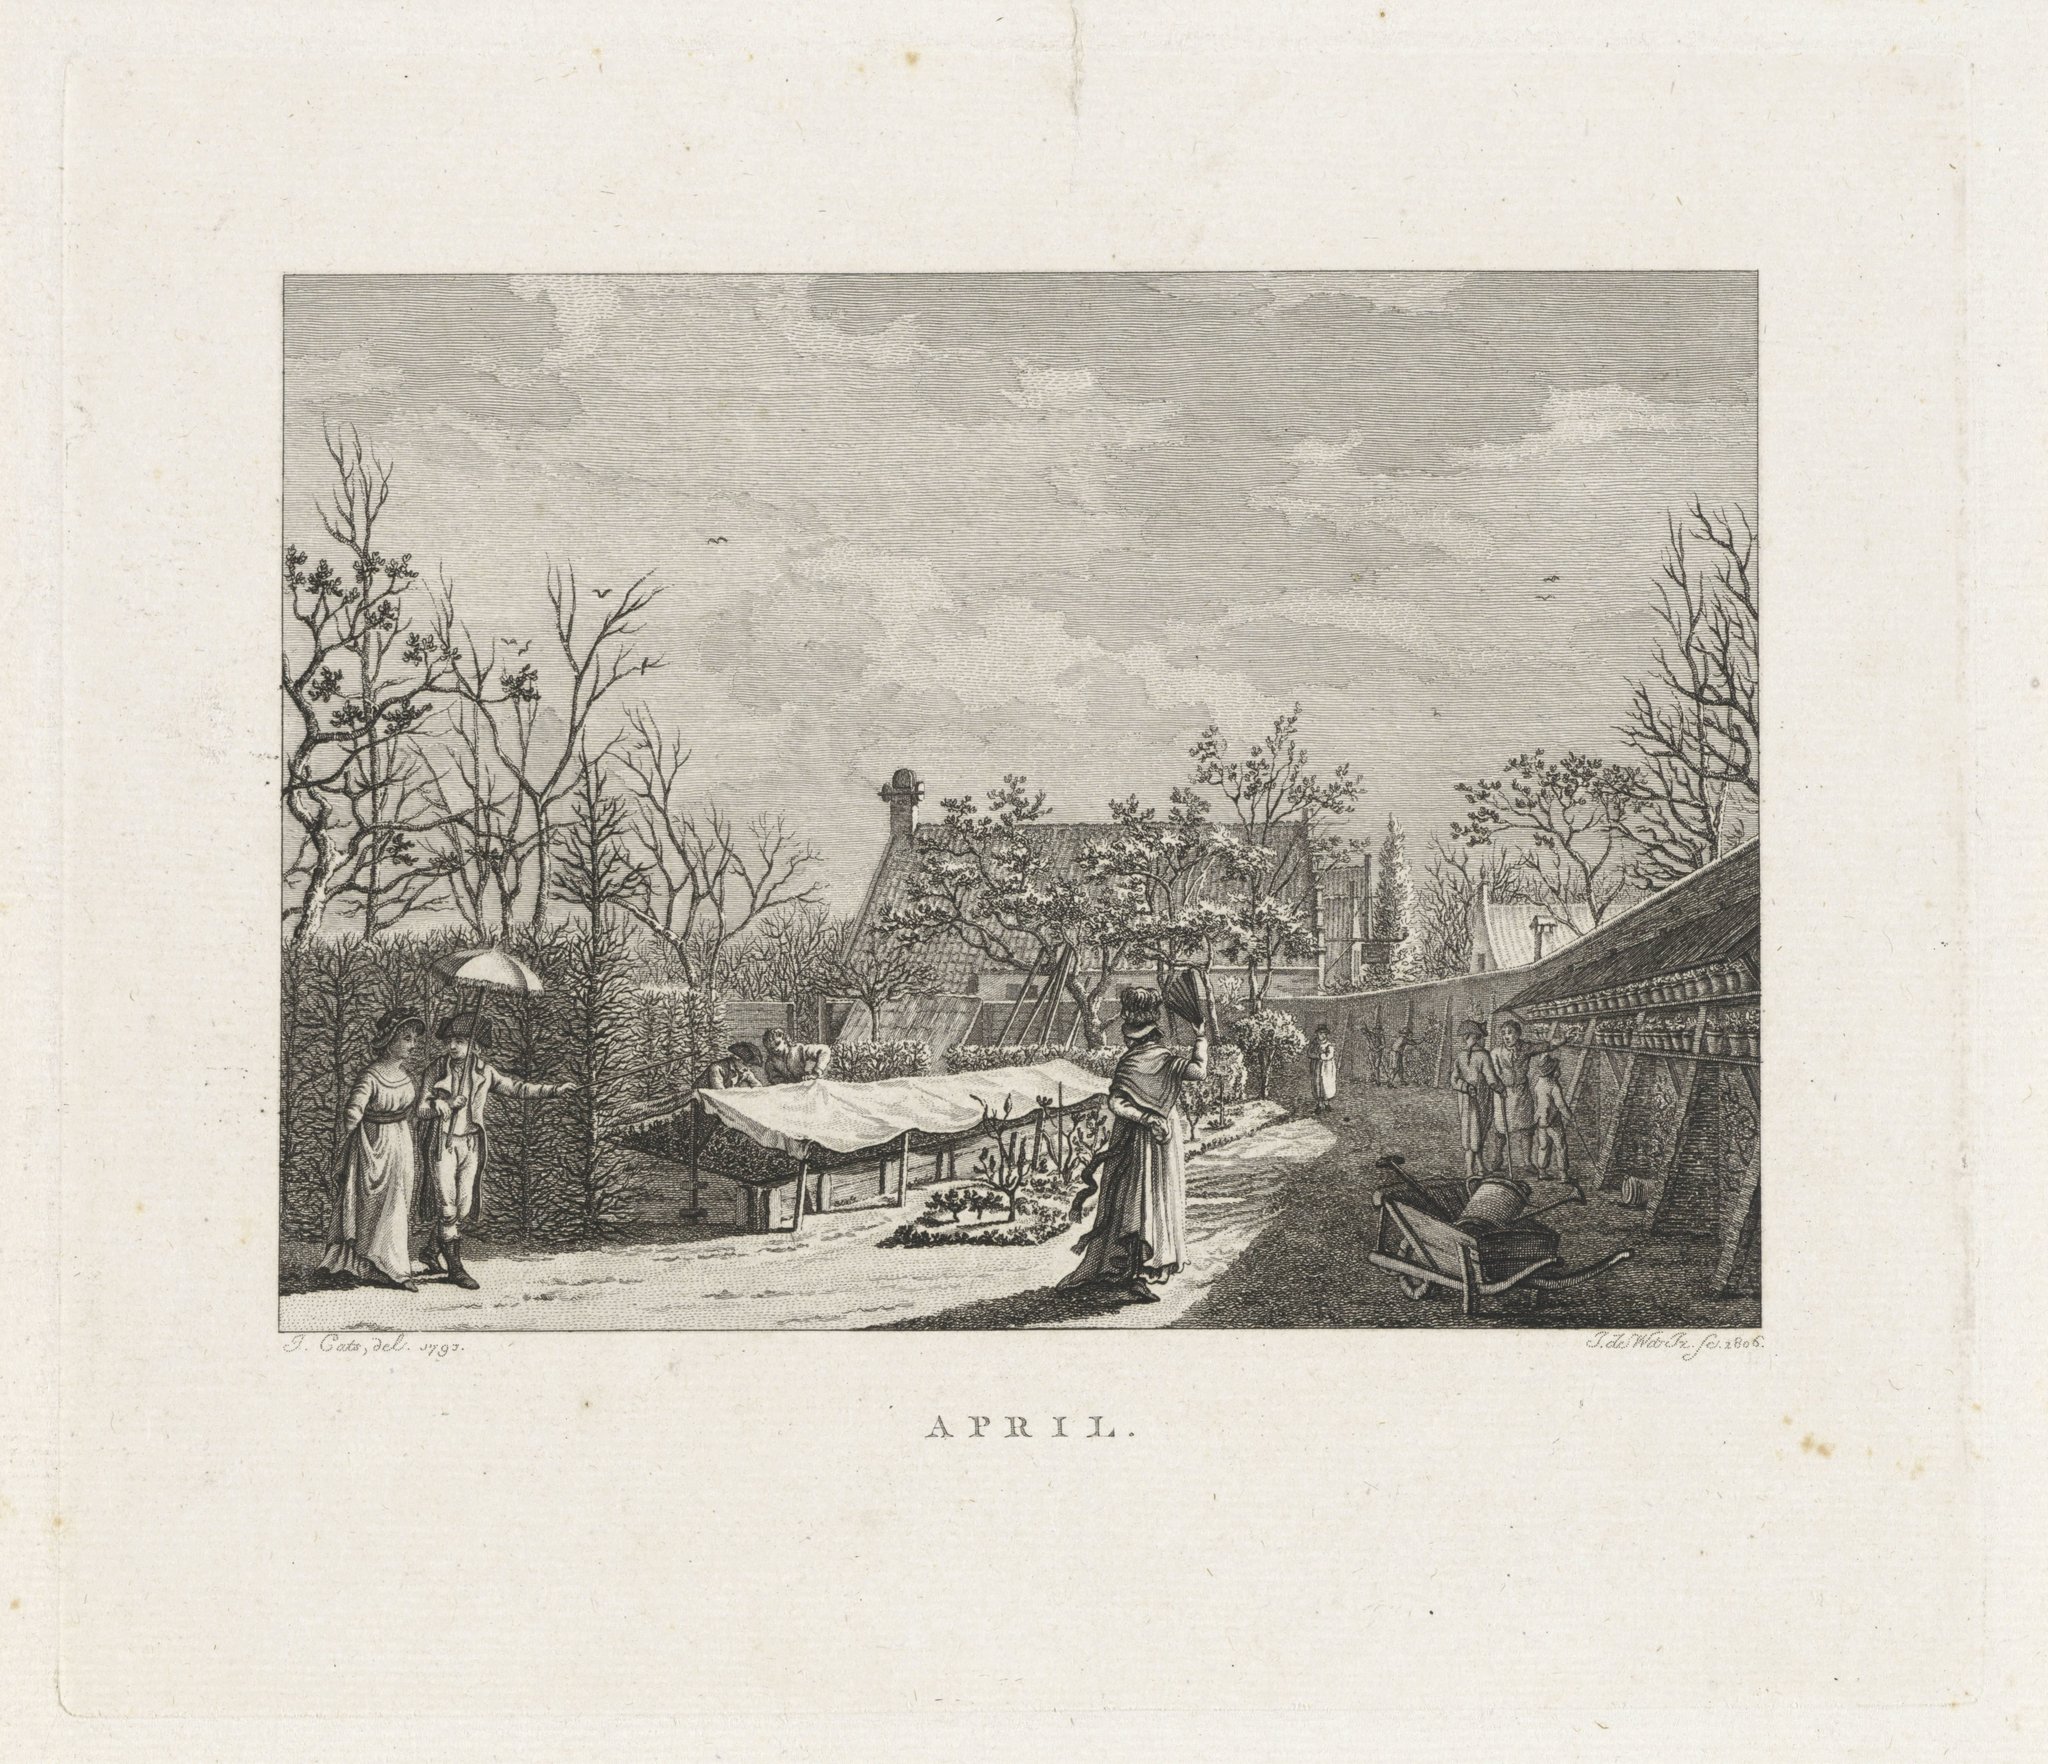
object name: print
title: Figuren in een ommuurde tuin met kweekbakken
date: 1806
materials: paper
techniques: etching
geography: haarlem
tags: forcing bed, april and its 'labours' (+ with scenes showing human occupations ~ seasons and months), gardening-tools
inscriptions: collector's mark: Lugt 2228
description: Bezoekers in een tuin of kwekerij bekijken planten. Op de voorgrond een kruiwagen met daarin een gieter en een schop.